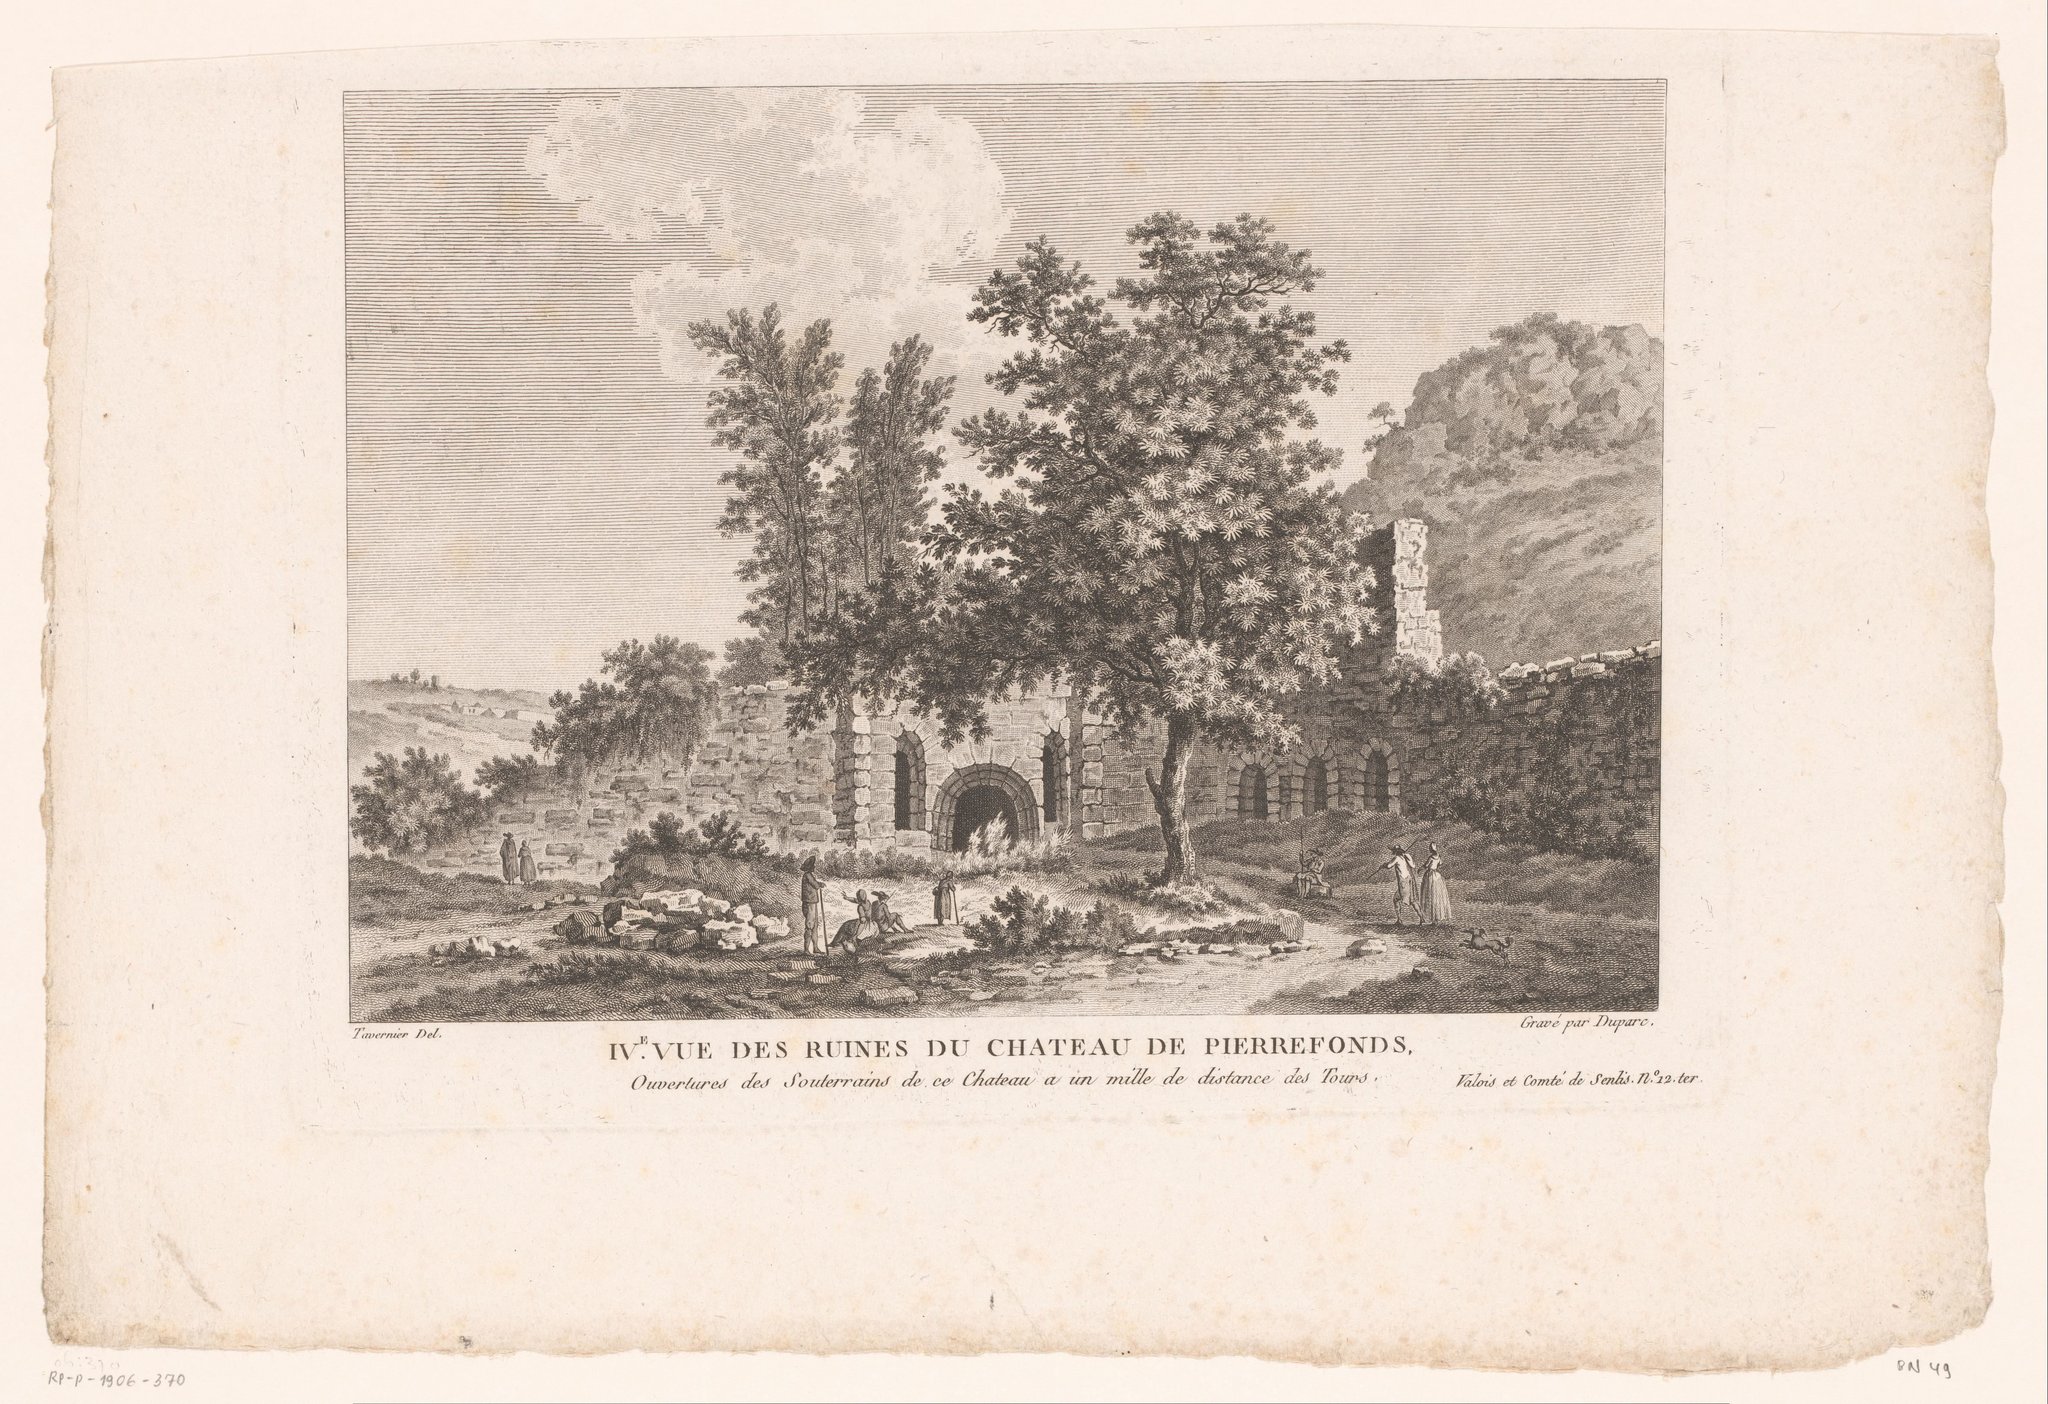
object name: print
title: IV.e Vue des ruines du chateau de Pierrefonds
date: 1765-1830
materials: paper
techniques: etching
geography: france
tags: landscape with ruins, ruin of a dwelling, house, castle, etc.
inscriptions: collector's mark: Lugt 2228